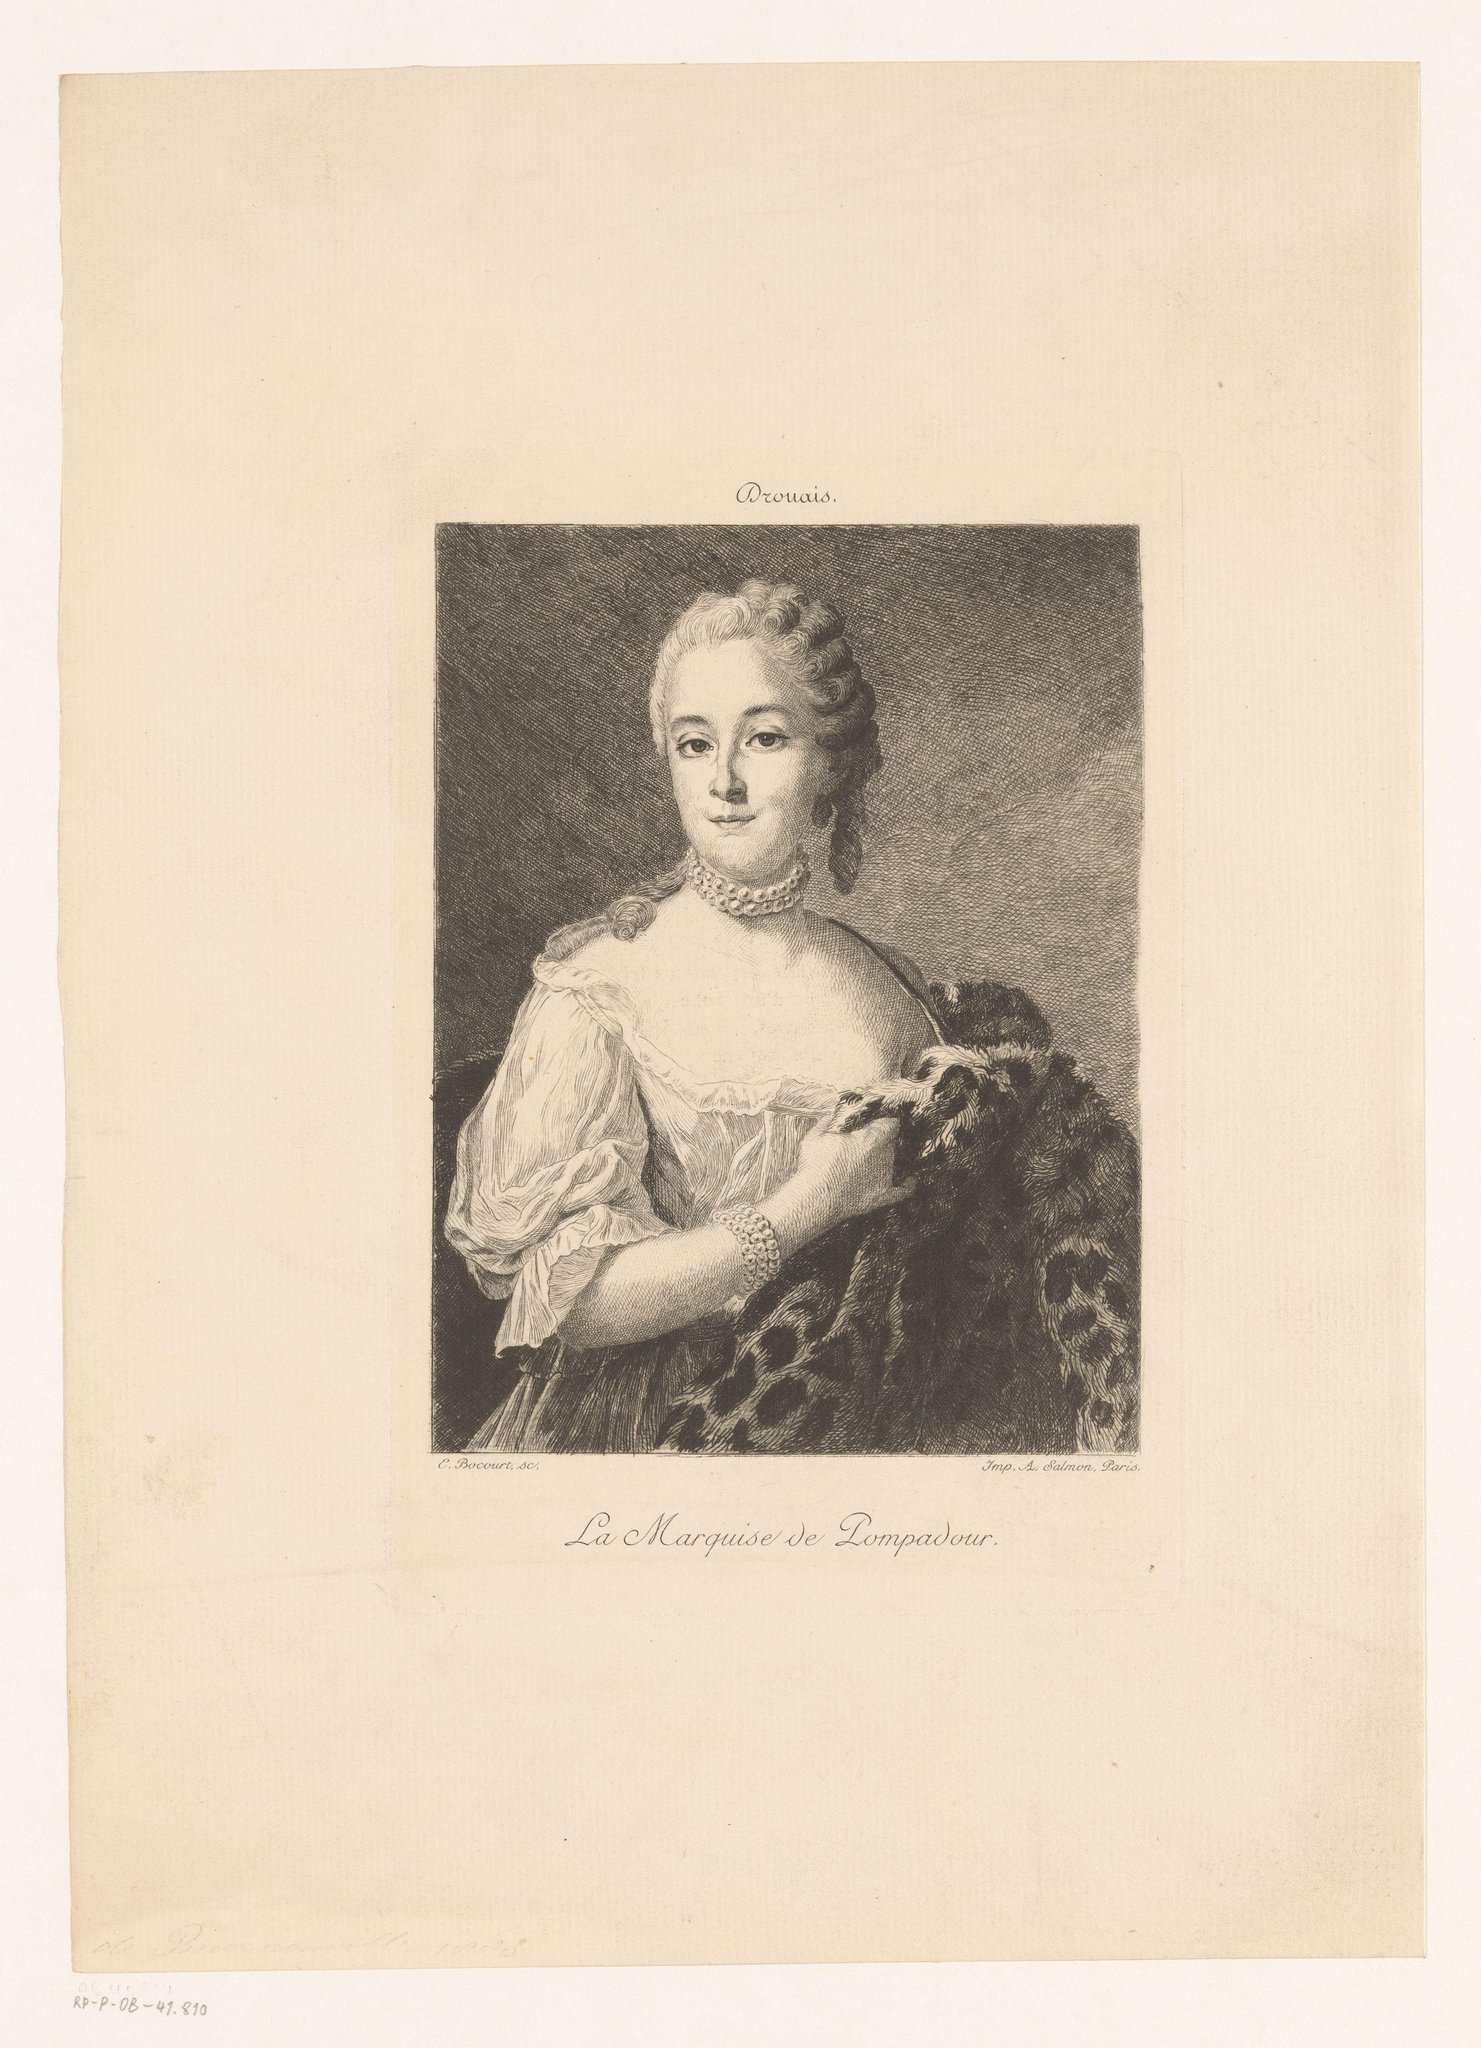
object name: print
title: La Marquise de Pompadour.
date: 1863-1882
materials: paper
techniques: drypoint, engraving, etching, intaglio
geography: france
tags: paris, print maker, madame de pompadour, historical persons, pearl; pearl necklace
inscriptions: collector's mark: Lugt 2228